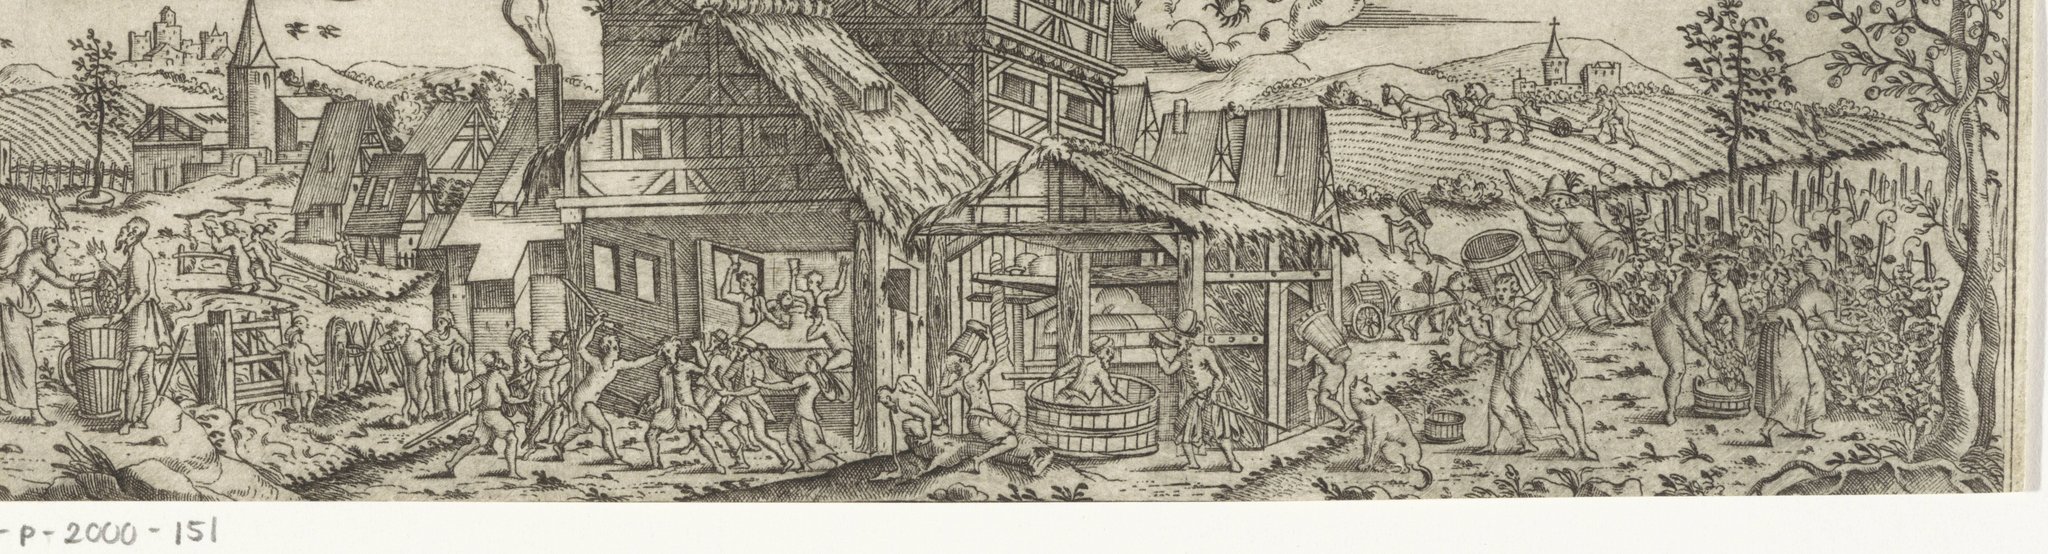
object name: print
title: Twaalf maanden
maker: Anonymous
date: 1554-1641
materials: paper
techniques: etching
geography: netherlands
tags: october and its 'labours'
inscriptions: collector's mark: Lugt 2760, collector's mark: Lugt 2228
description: De bezigheden in de maand oktober. Links en rechts de druivenoogst. In het midden worden de druiven gestampt en de wijn geproduceerd. In een herberg wordt wijn gedronken en voor het gebouw wordt gevochten. In de lucht het dierenriemteken Schorpioen.